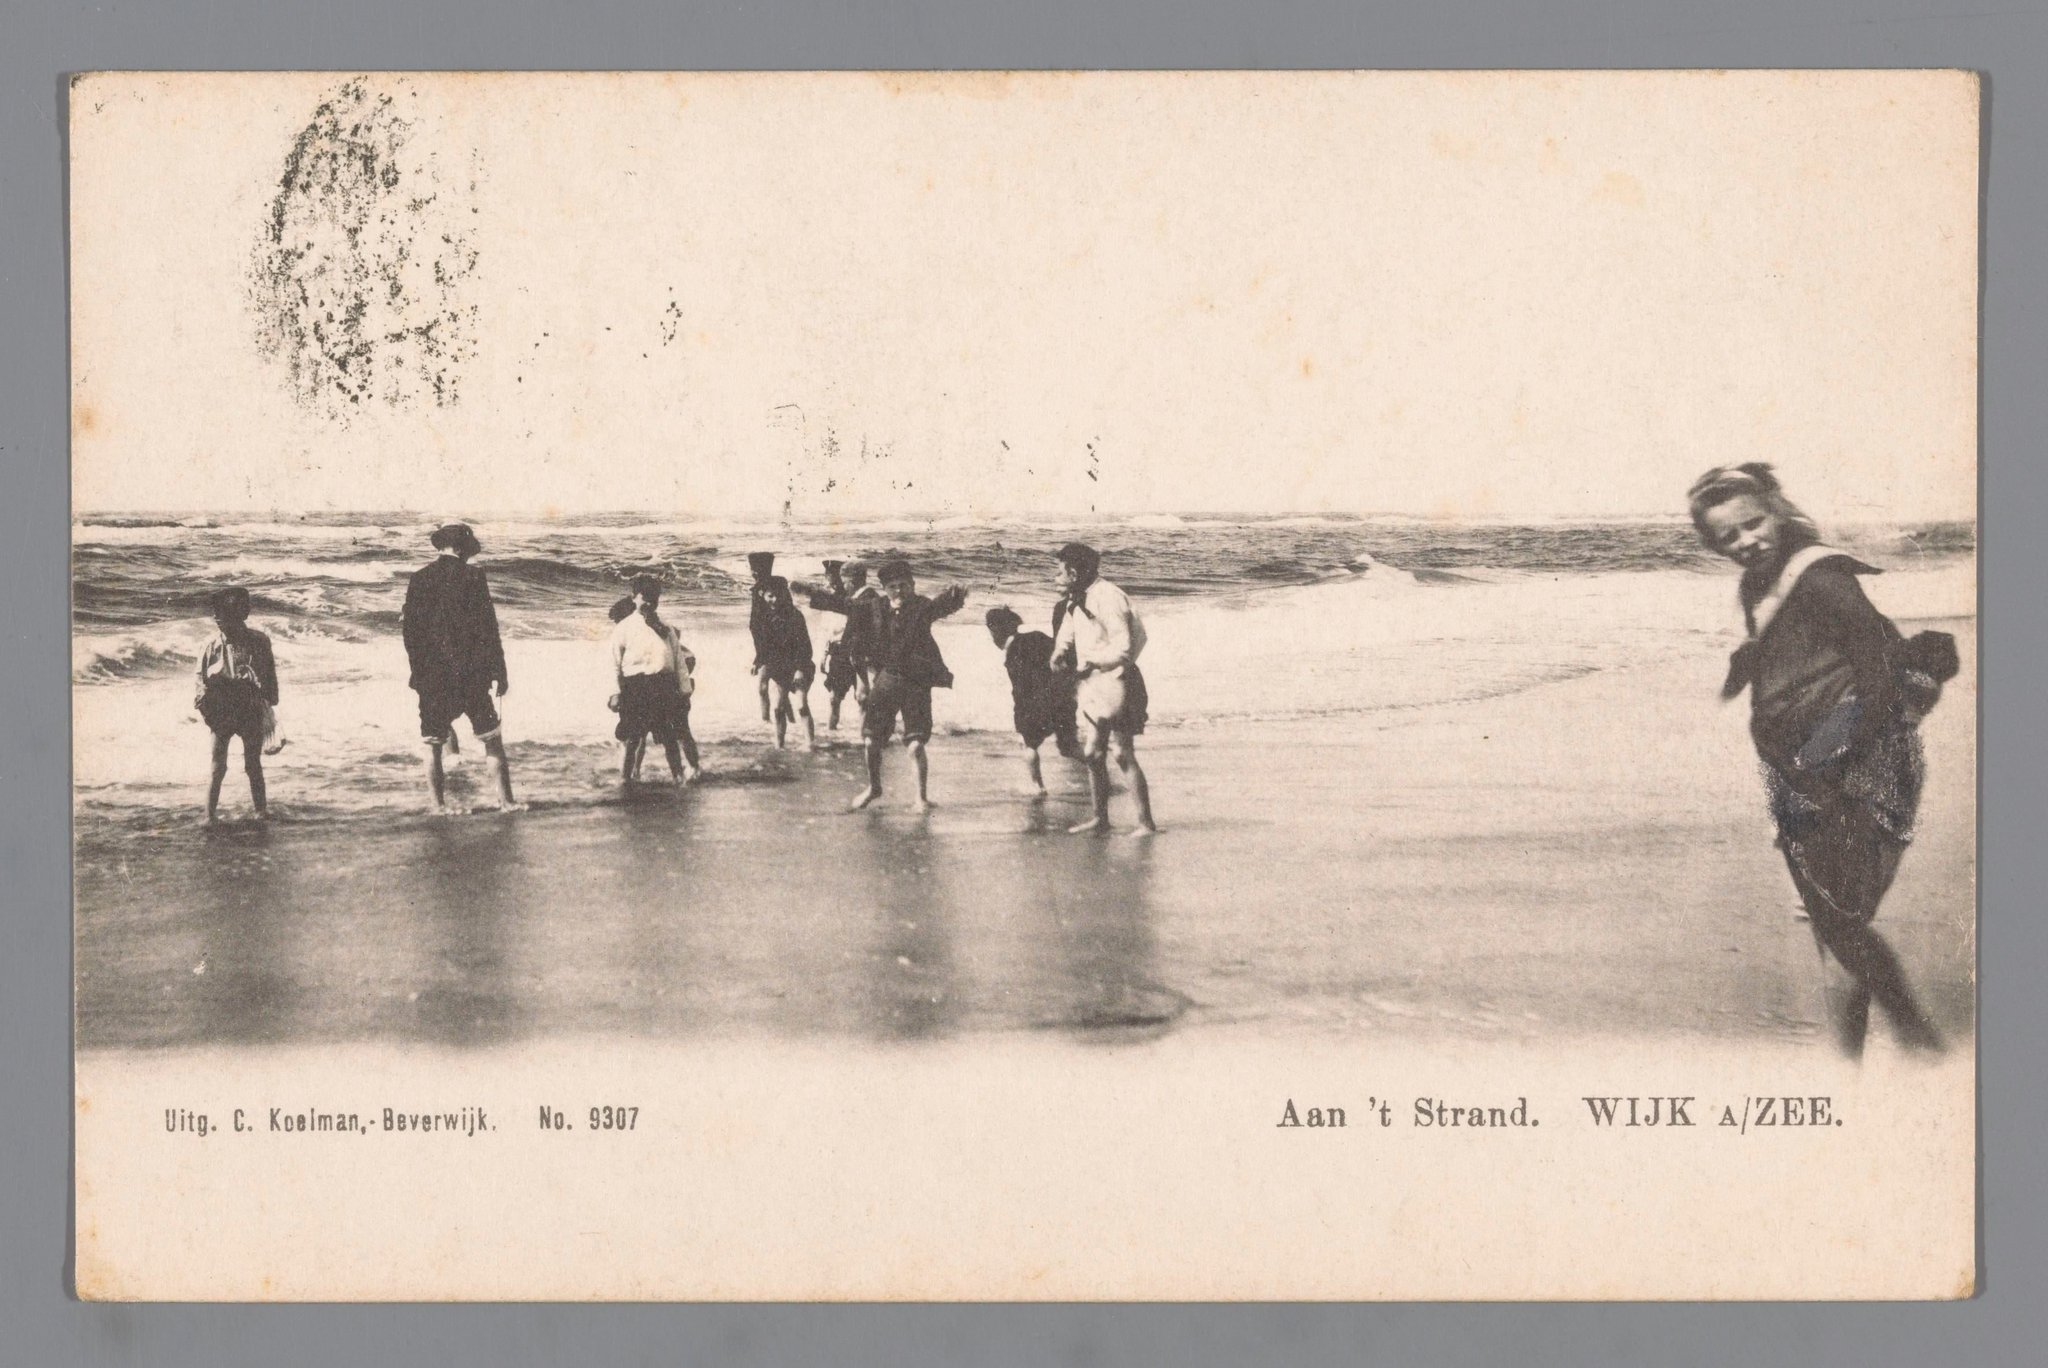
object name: photograph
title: Aan 't Strand, Wijk aan Zee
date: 1908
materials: cardboard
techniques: photograph, writing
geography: beverwijk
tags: coast